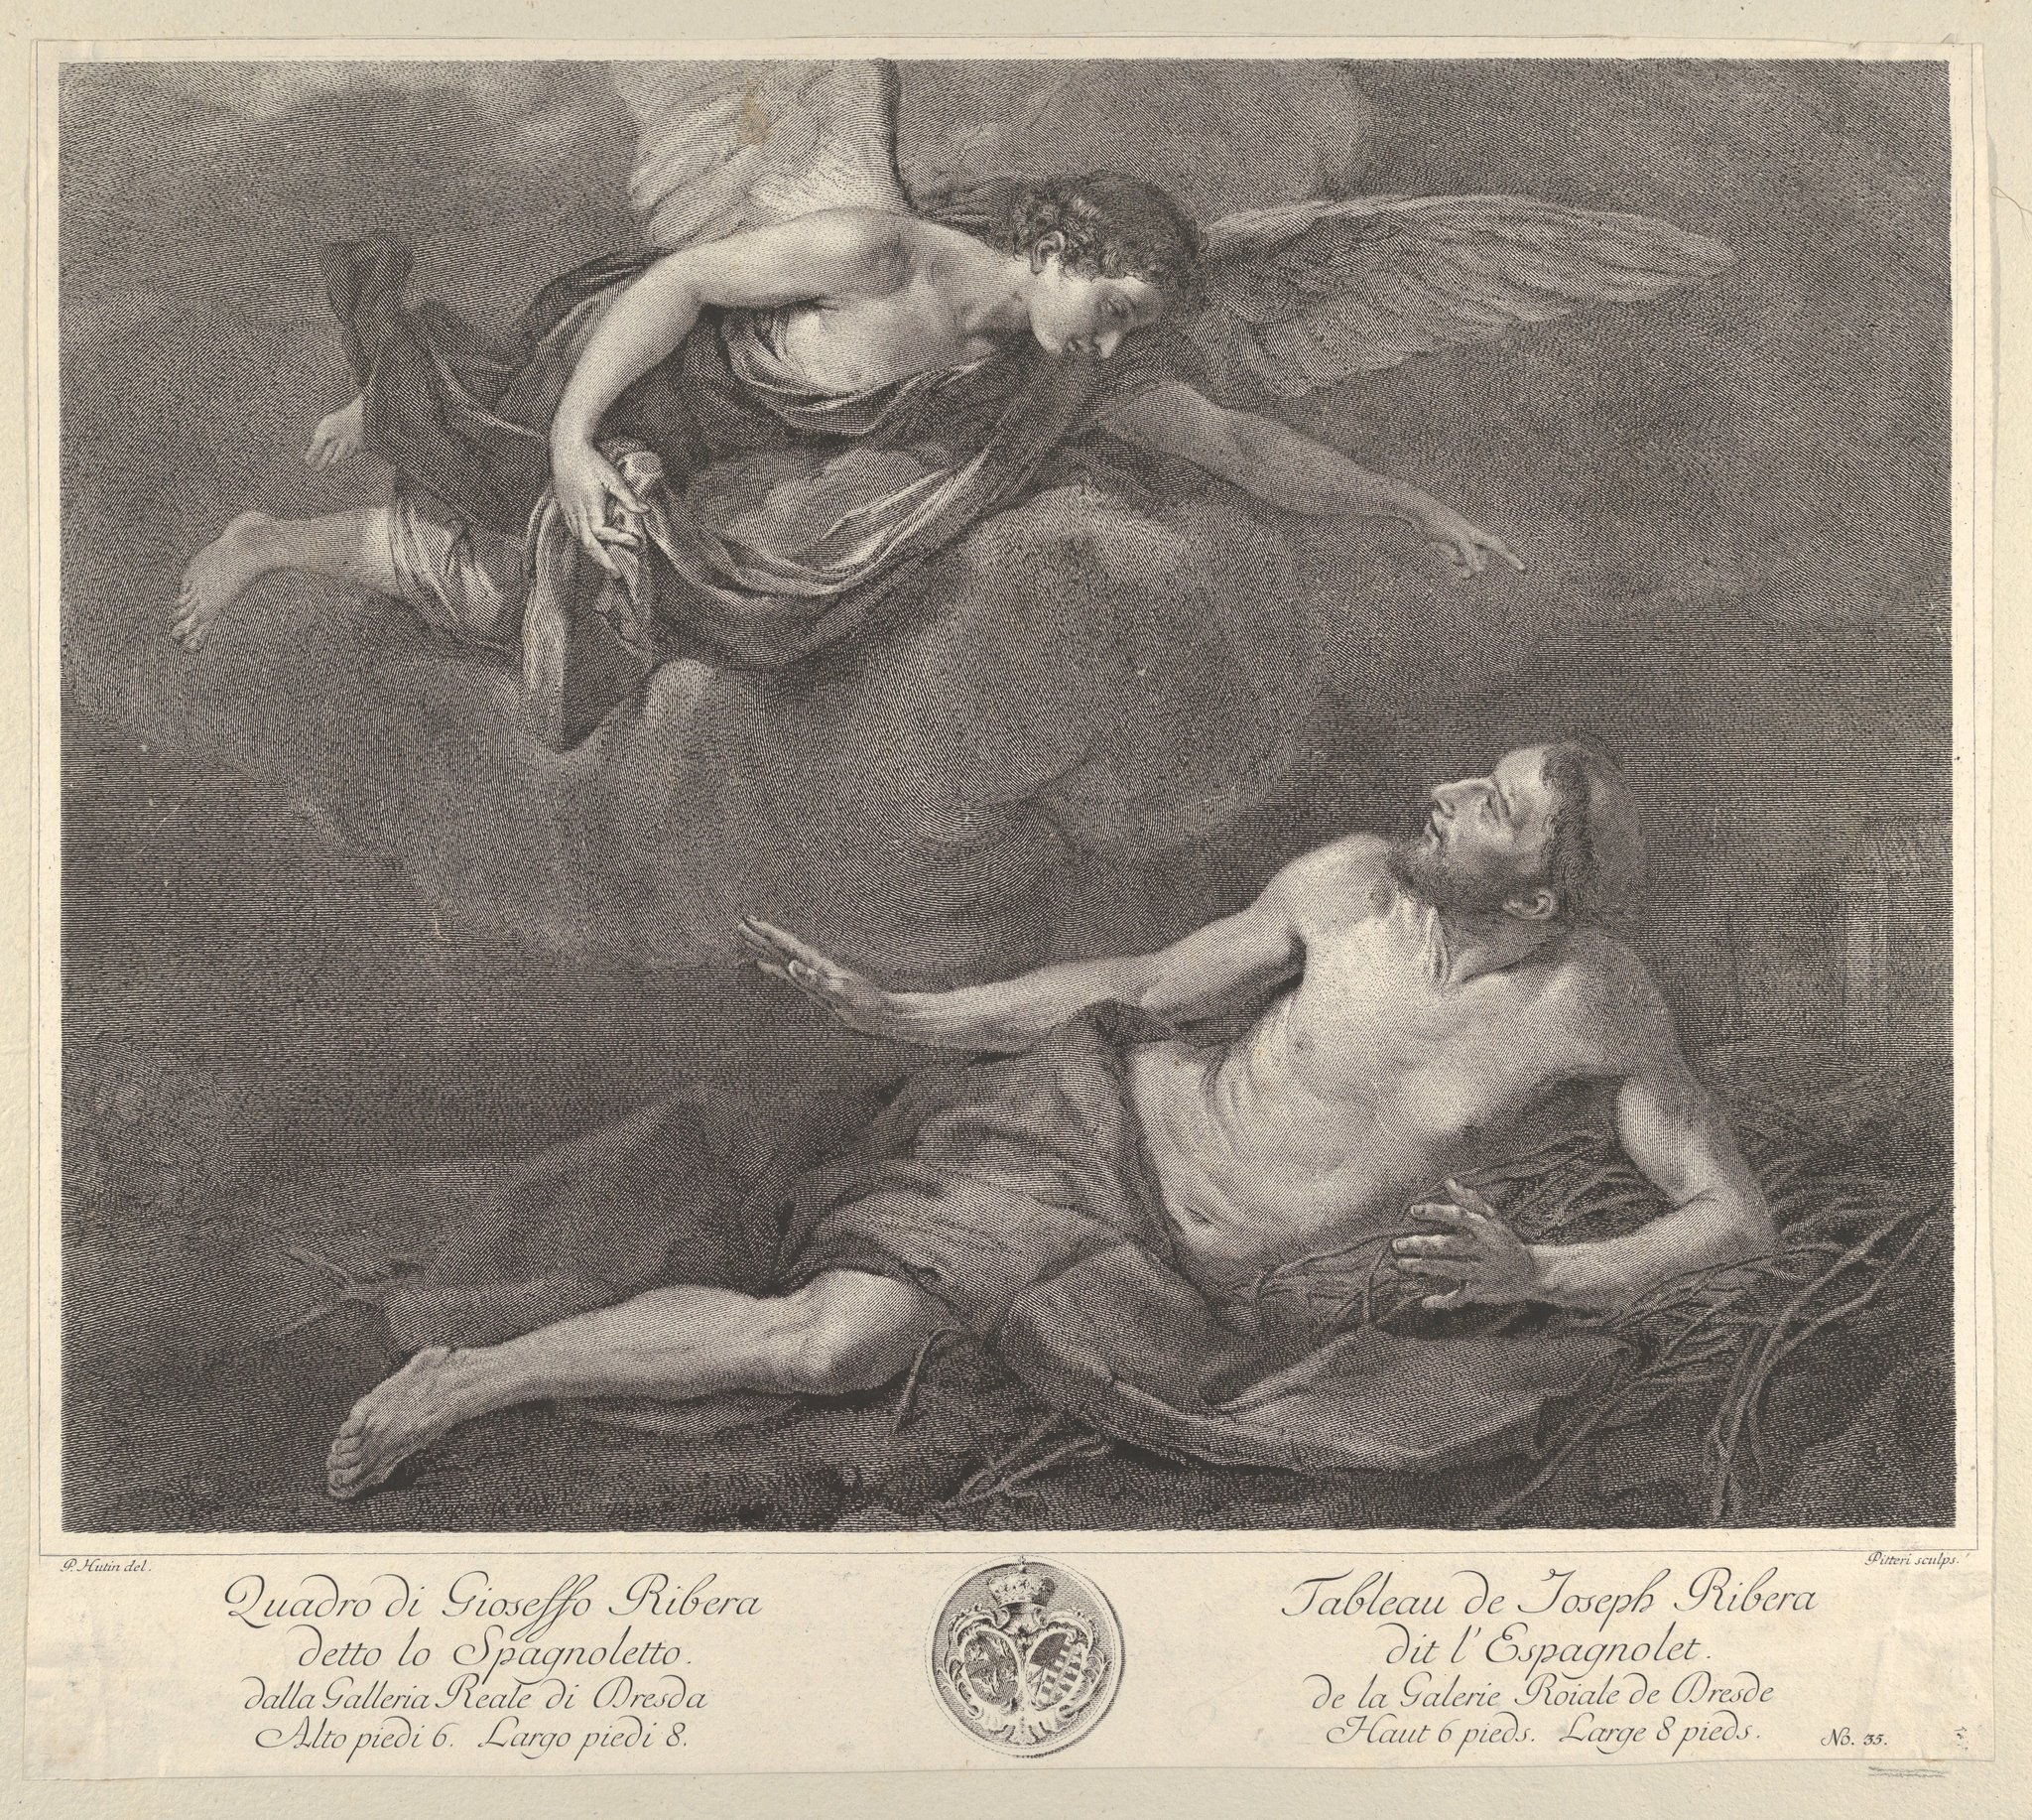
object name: print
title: Saint Francis visited by the Angel, from 'Recueil d'estampes d'après les plus célèbres tableaux de la Galerie Royale de Dresde'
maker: marco alvise pitteri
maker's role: artist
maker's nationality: italian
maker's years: 1702-1786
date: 1730-1786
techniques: etching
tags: angels,saint francis,coat of arms